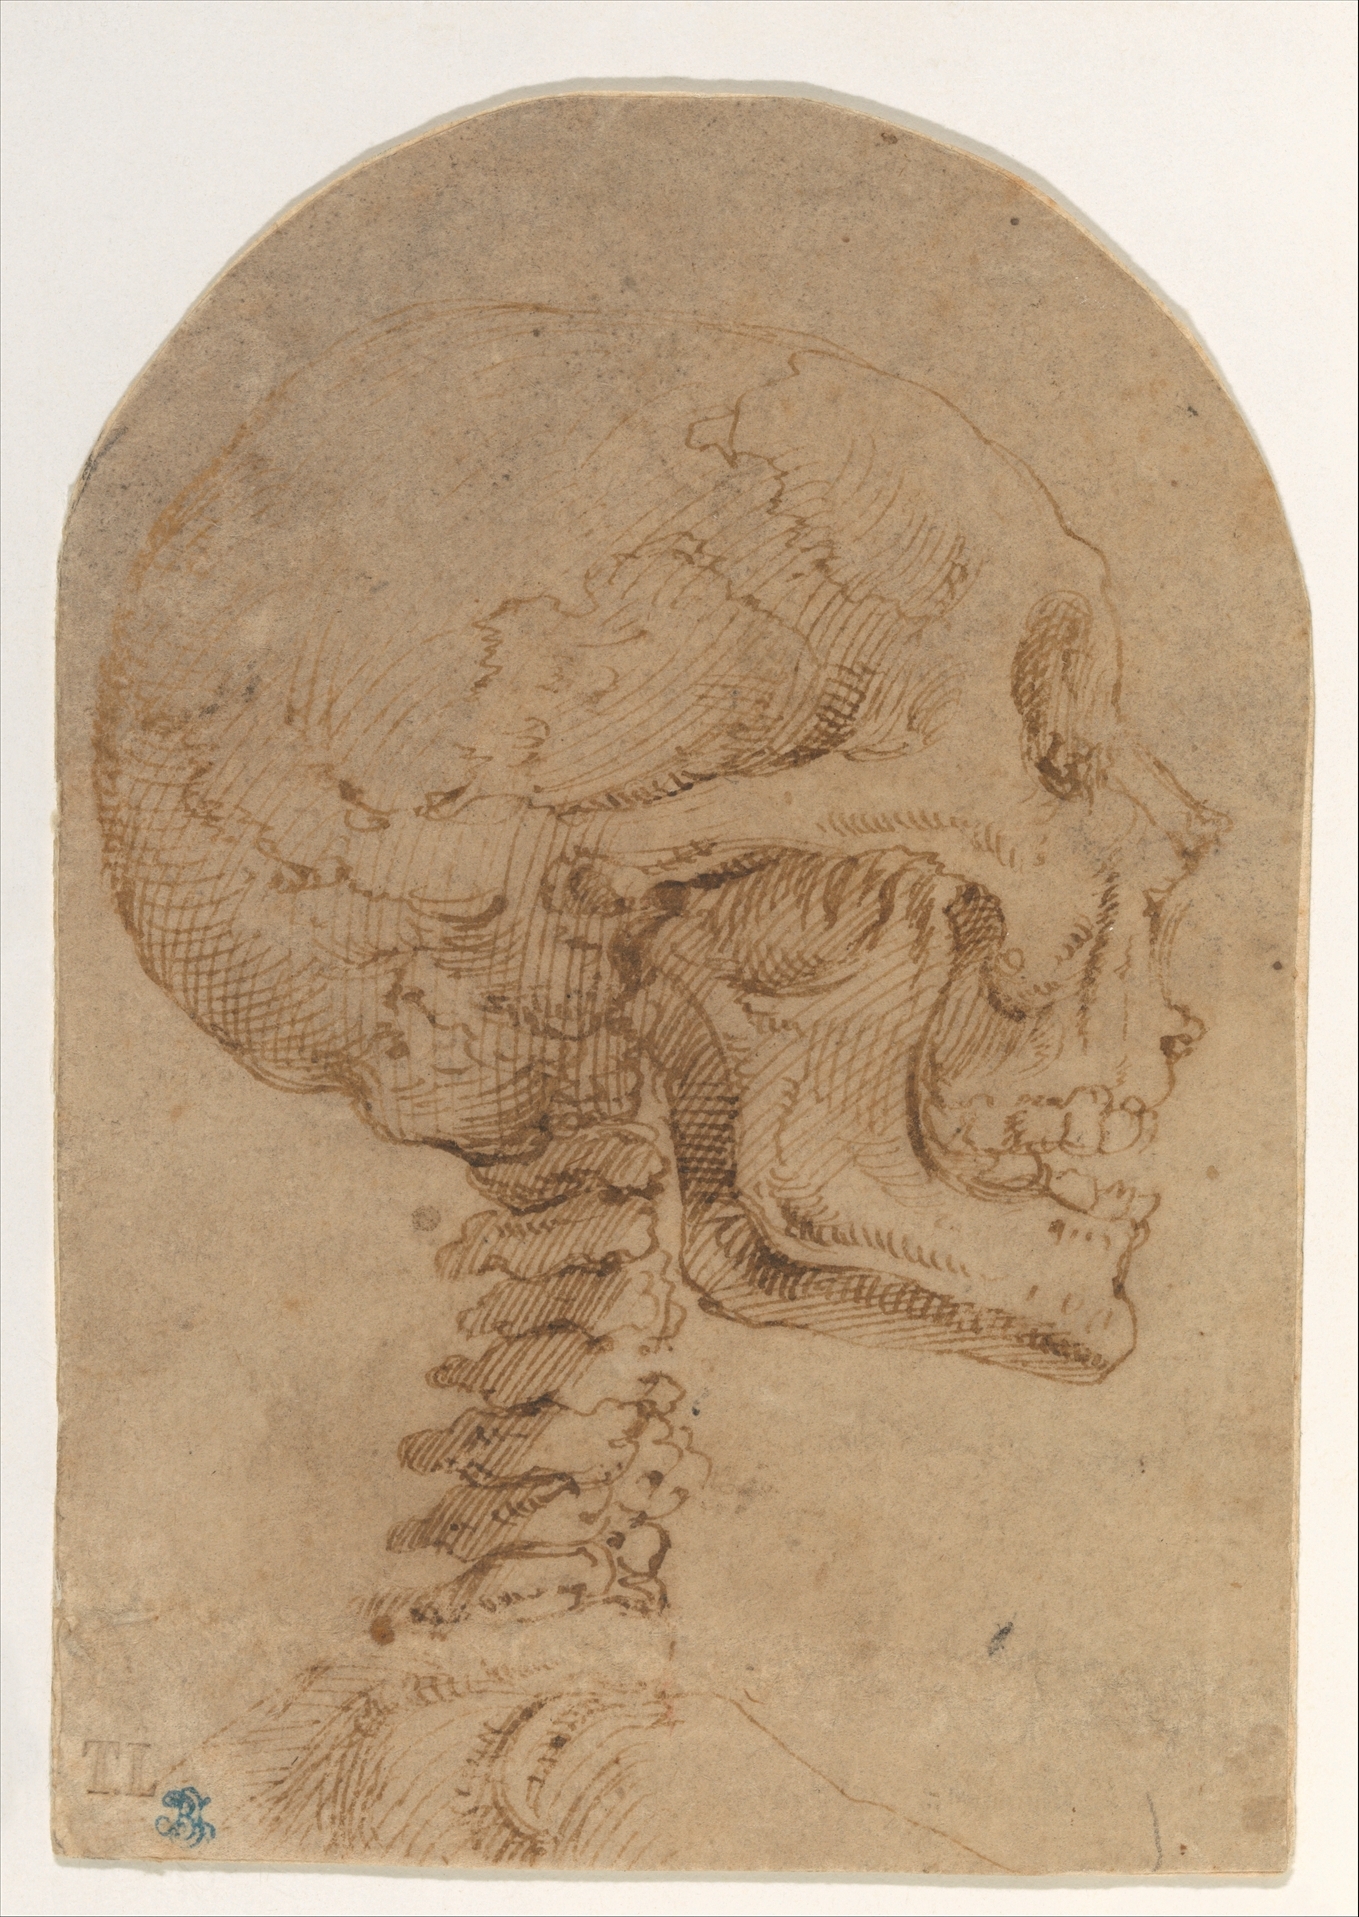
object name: drawing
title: Skull in Profile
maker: battista franco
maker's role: artist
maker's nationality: italian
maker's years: 1510-1561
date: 1538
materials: ink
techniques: pen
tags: skulls